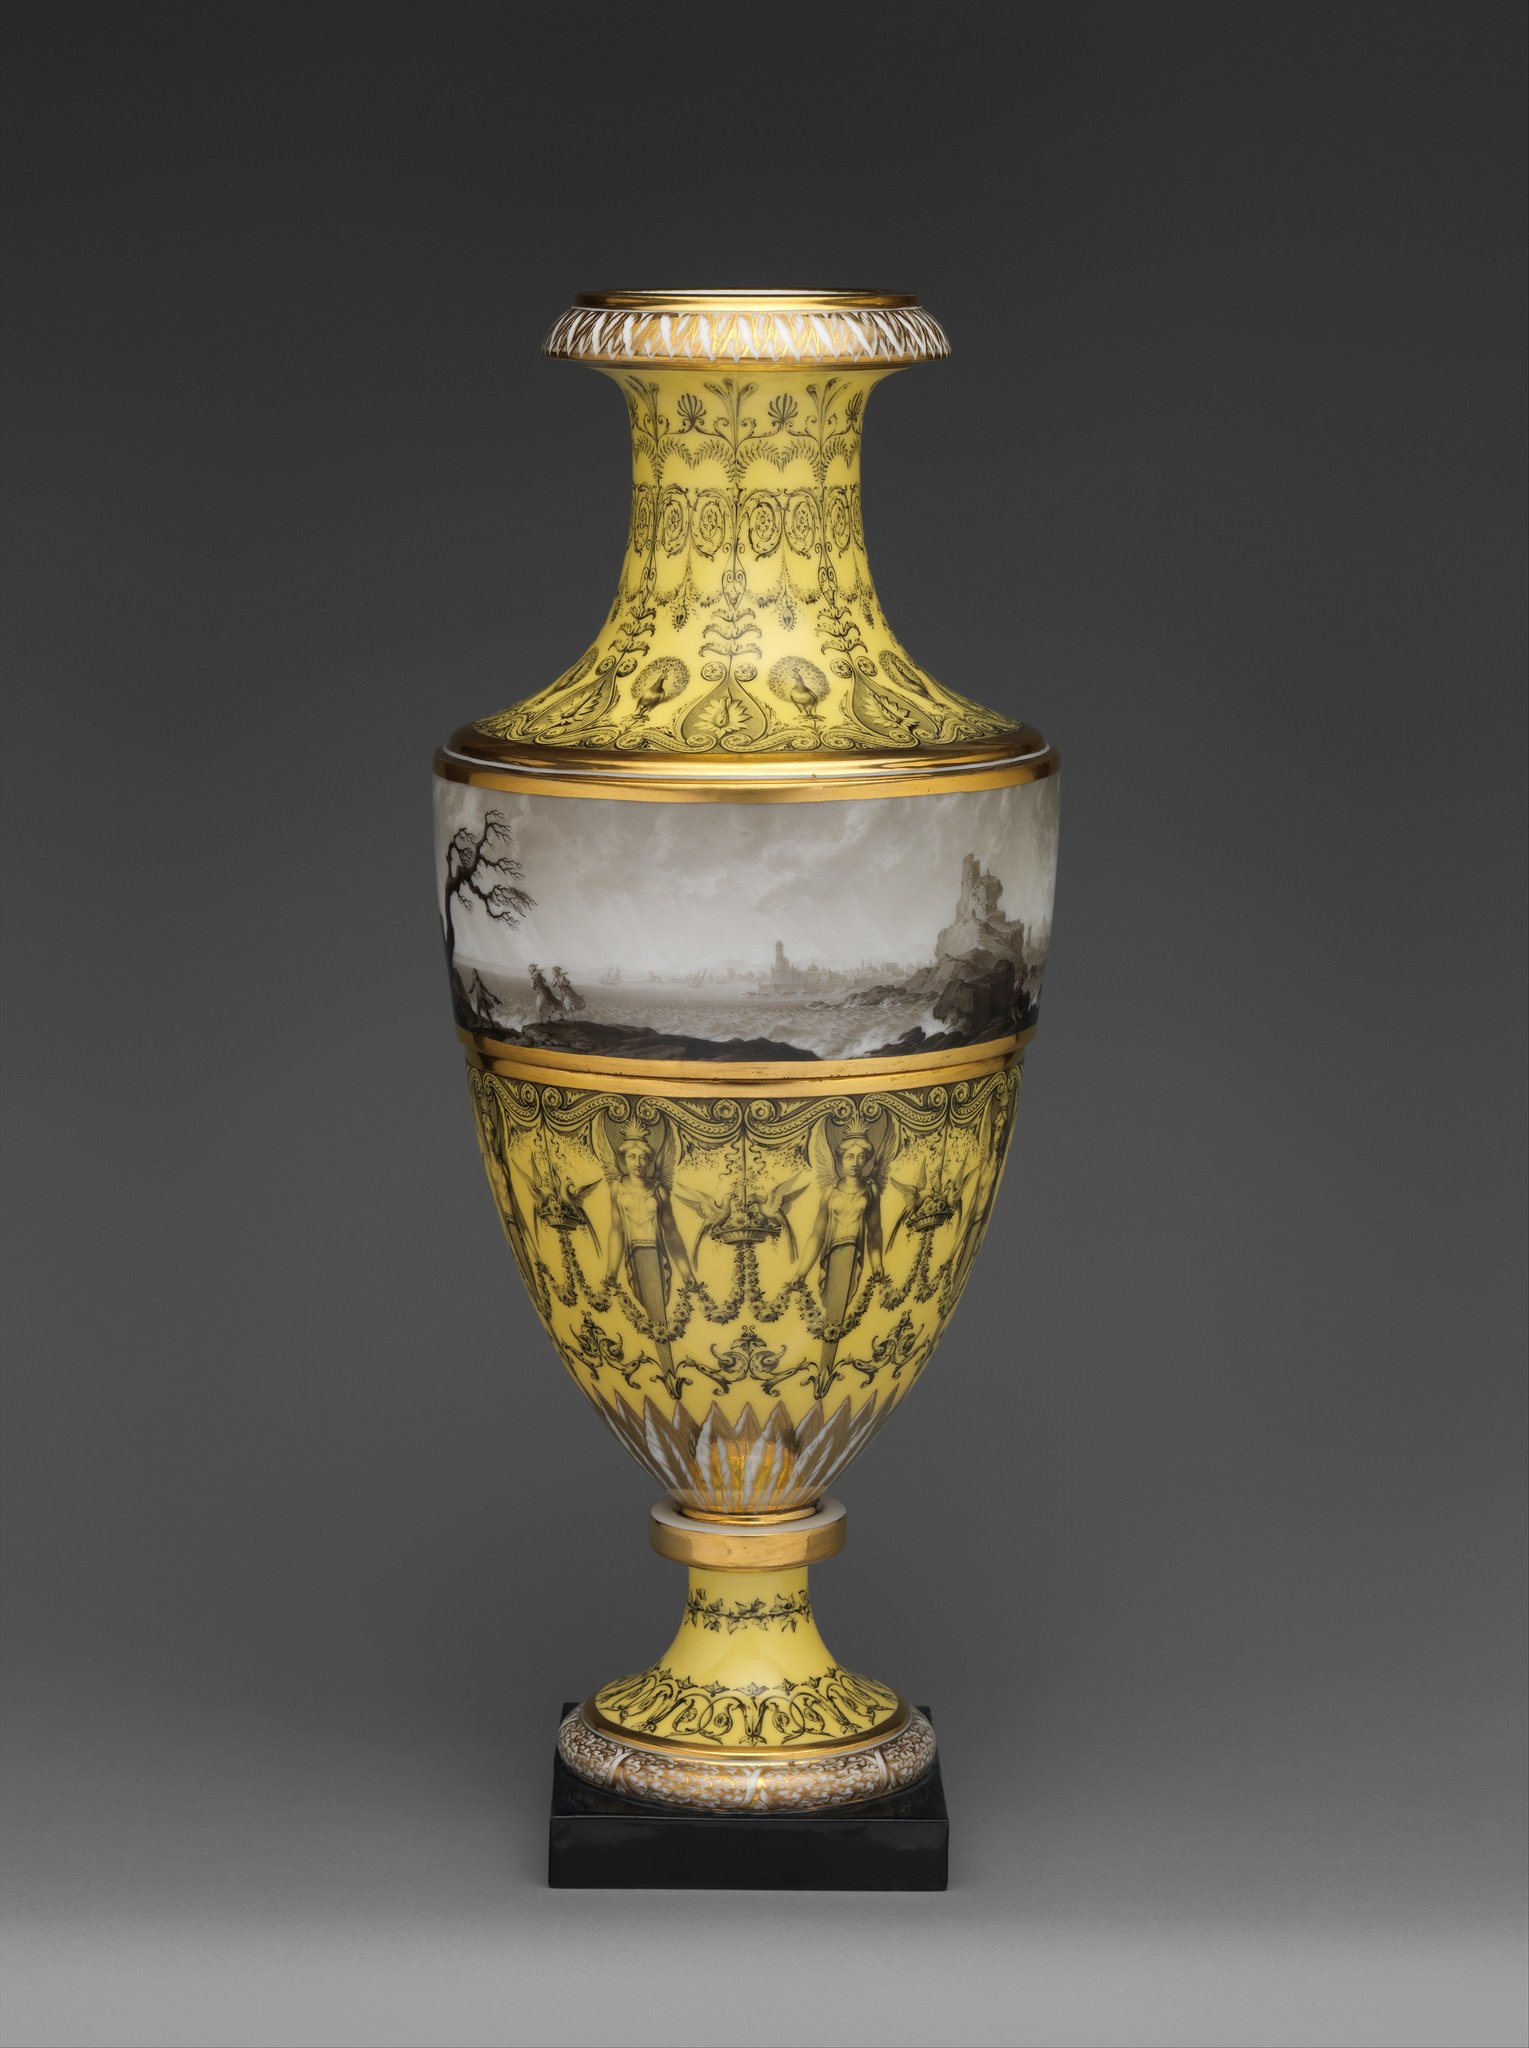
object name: vase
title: Vase with scenes of storm at sea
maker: dihl et guérhard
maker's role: manufacturer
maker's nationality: french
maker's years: 1781-1824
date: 1797-1798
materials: enamel, gold, hard paste porcelain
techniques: polychrome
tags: seas,storms